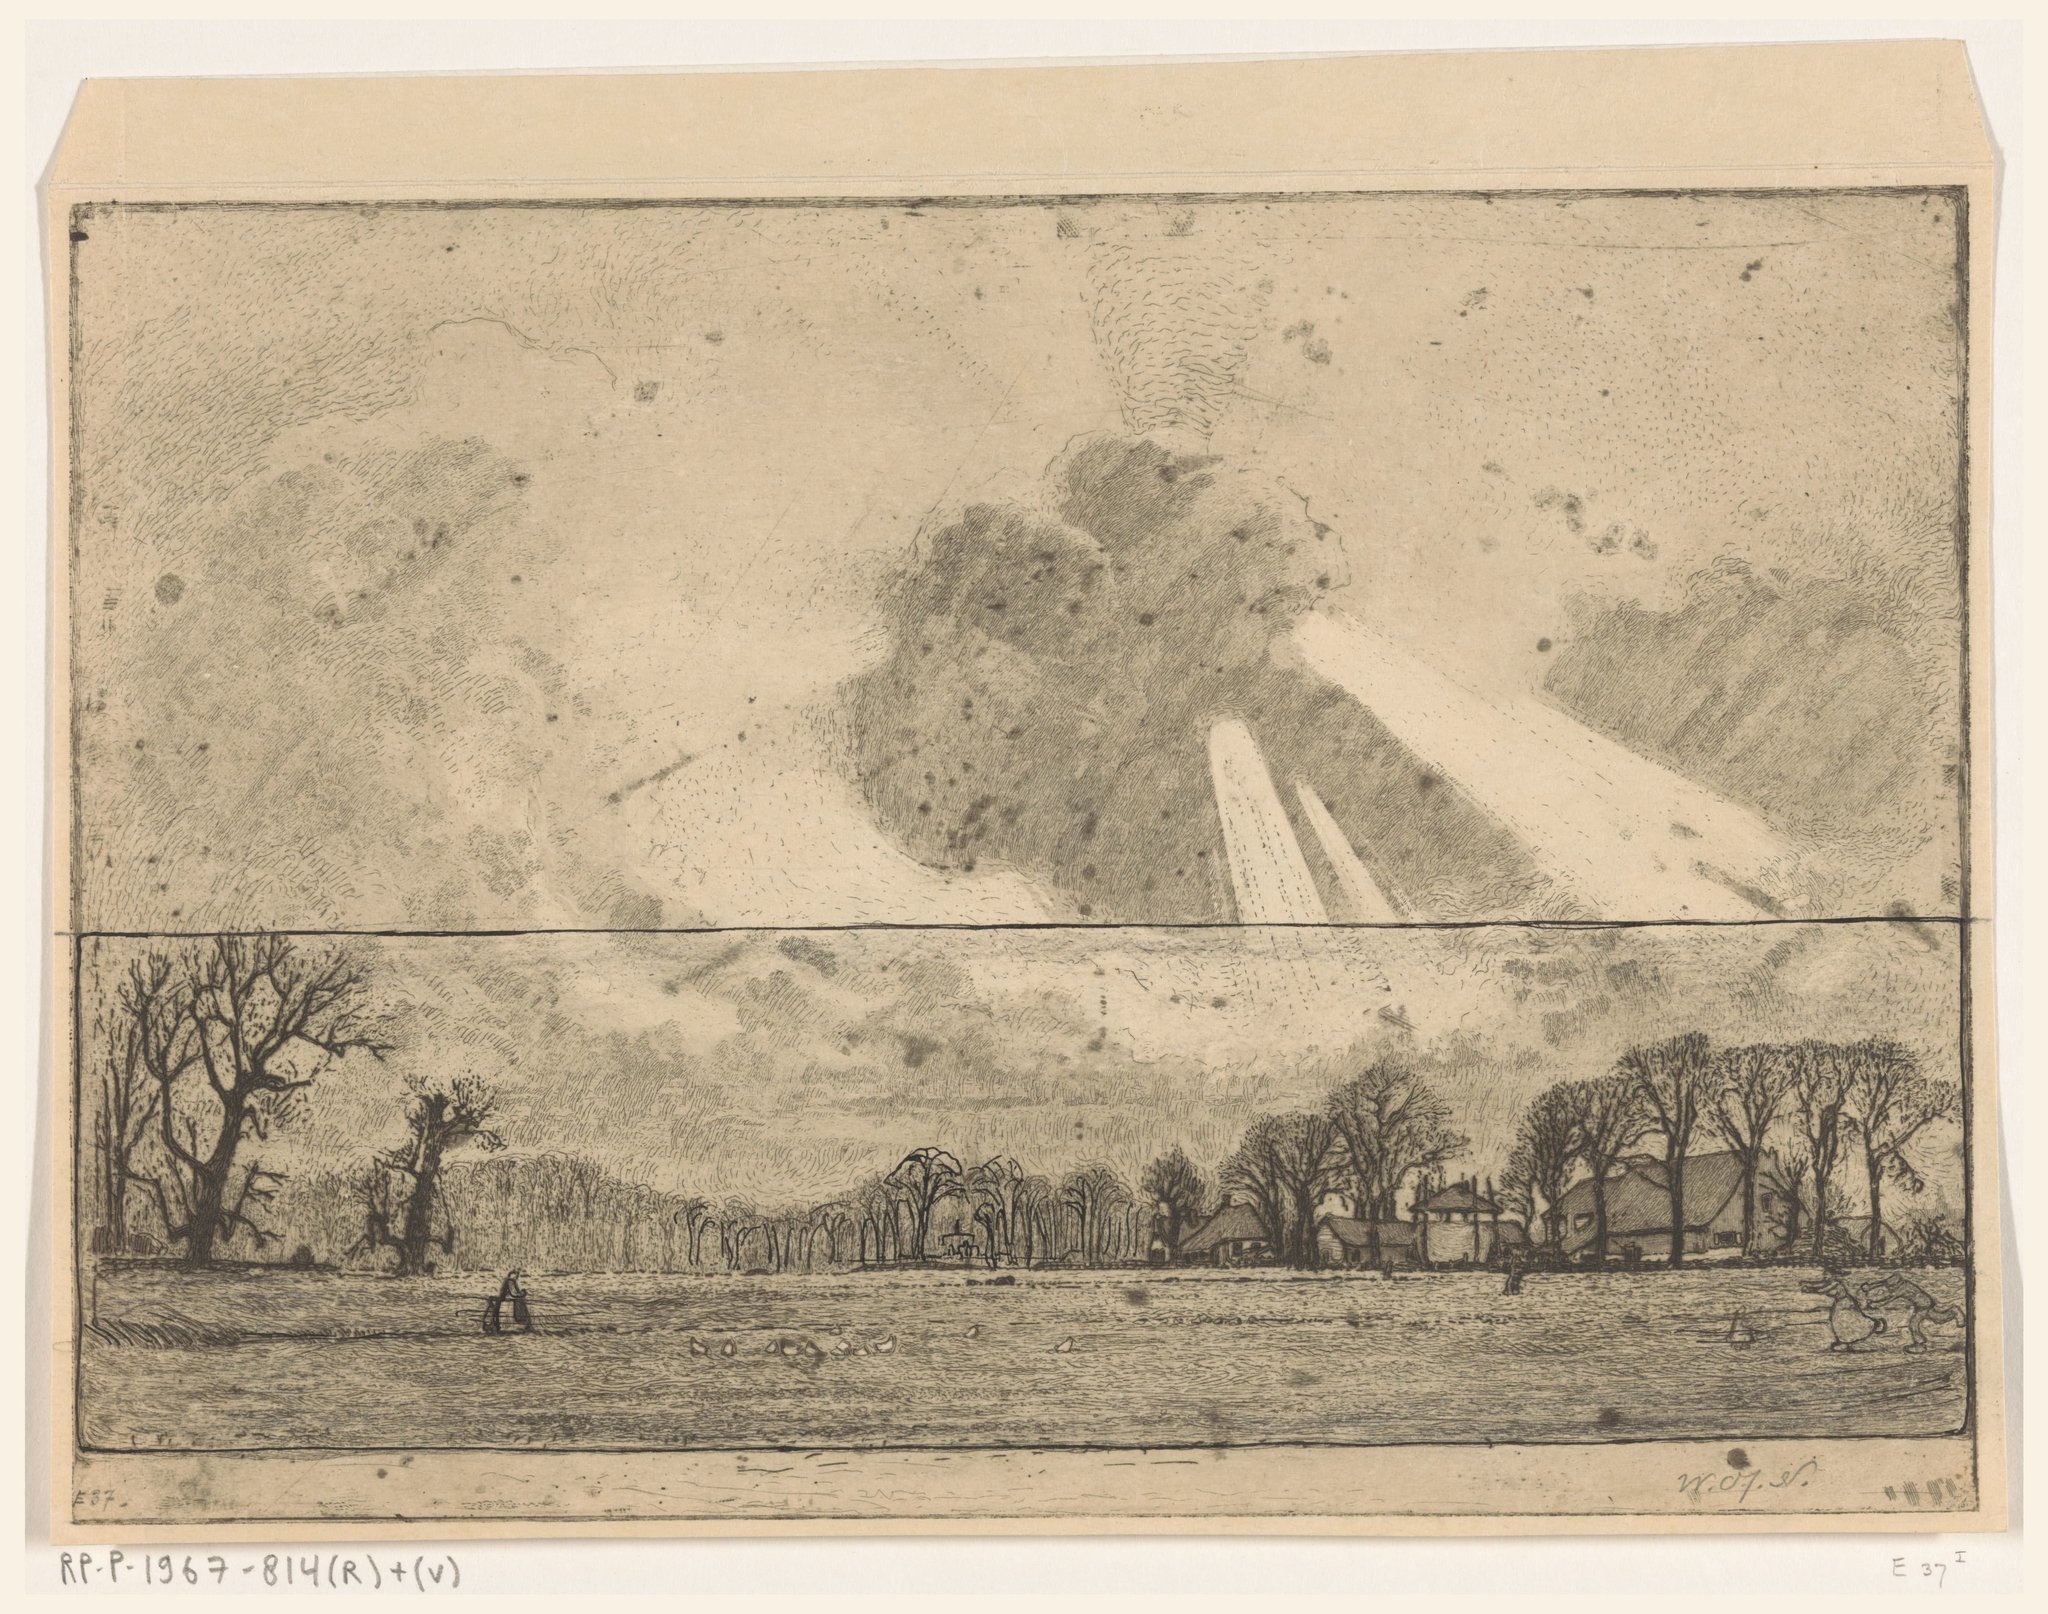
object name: print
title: Boerderij bij Santpoort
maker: wijnand otto jan nieuwenkamp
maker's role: draughtsman, print maker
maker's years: 1874-1950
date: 1899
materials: paper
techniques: intaglio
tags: farm or solitary house in landscape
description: Op de voorgrond enkele figuren in een weiland. Op de achtergrond bomen met kale takken. In het midden een horizontale lijn die de plaat in een onder- en bovengedeelte verdeelt.